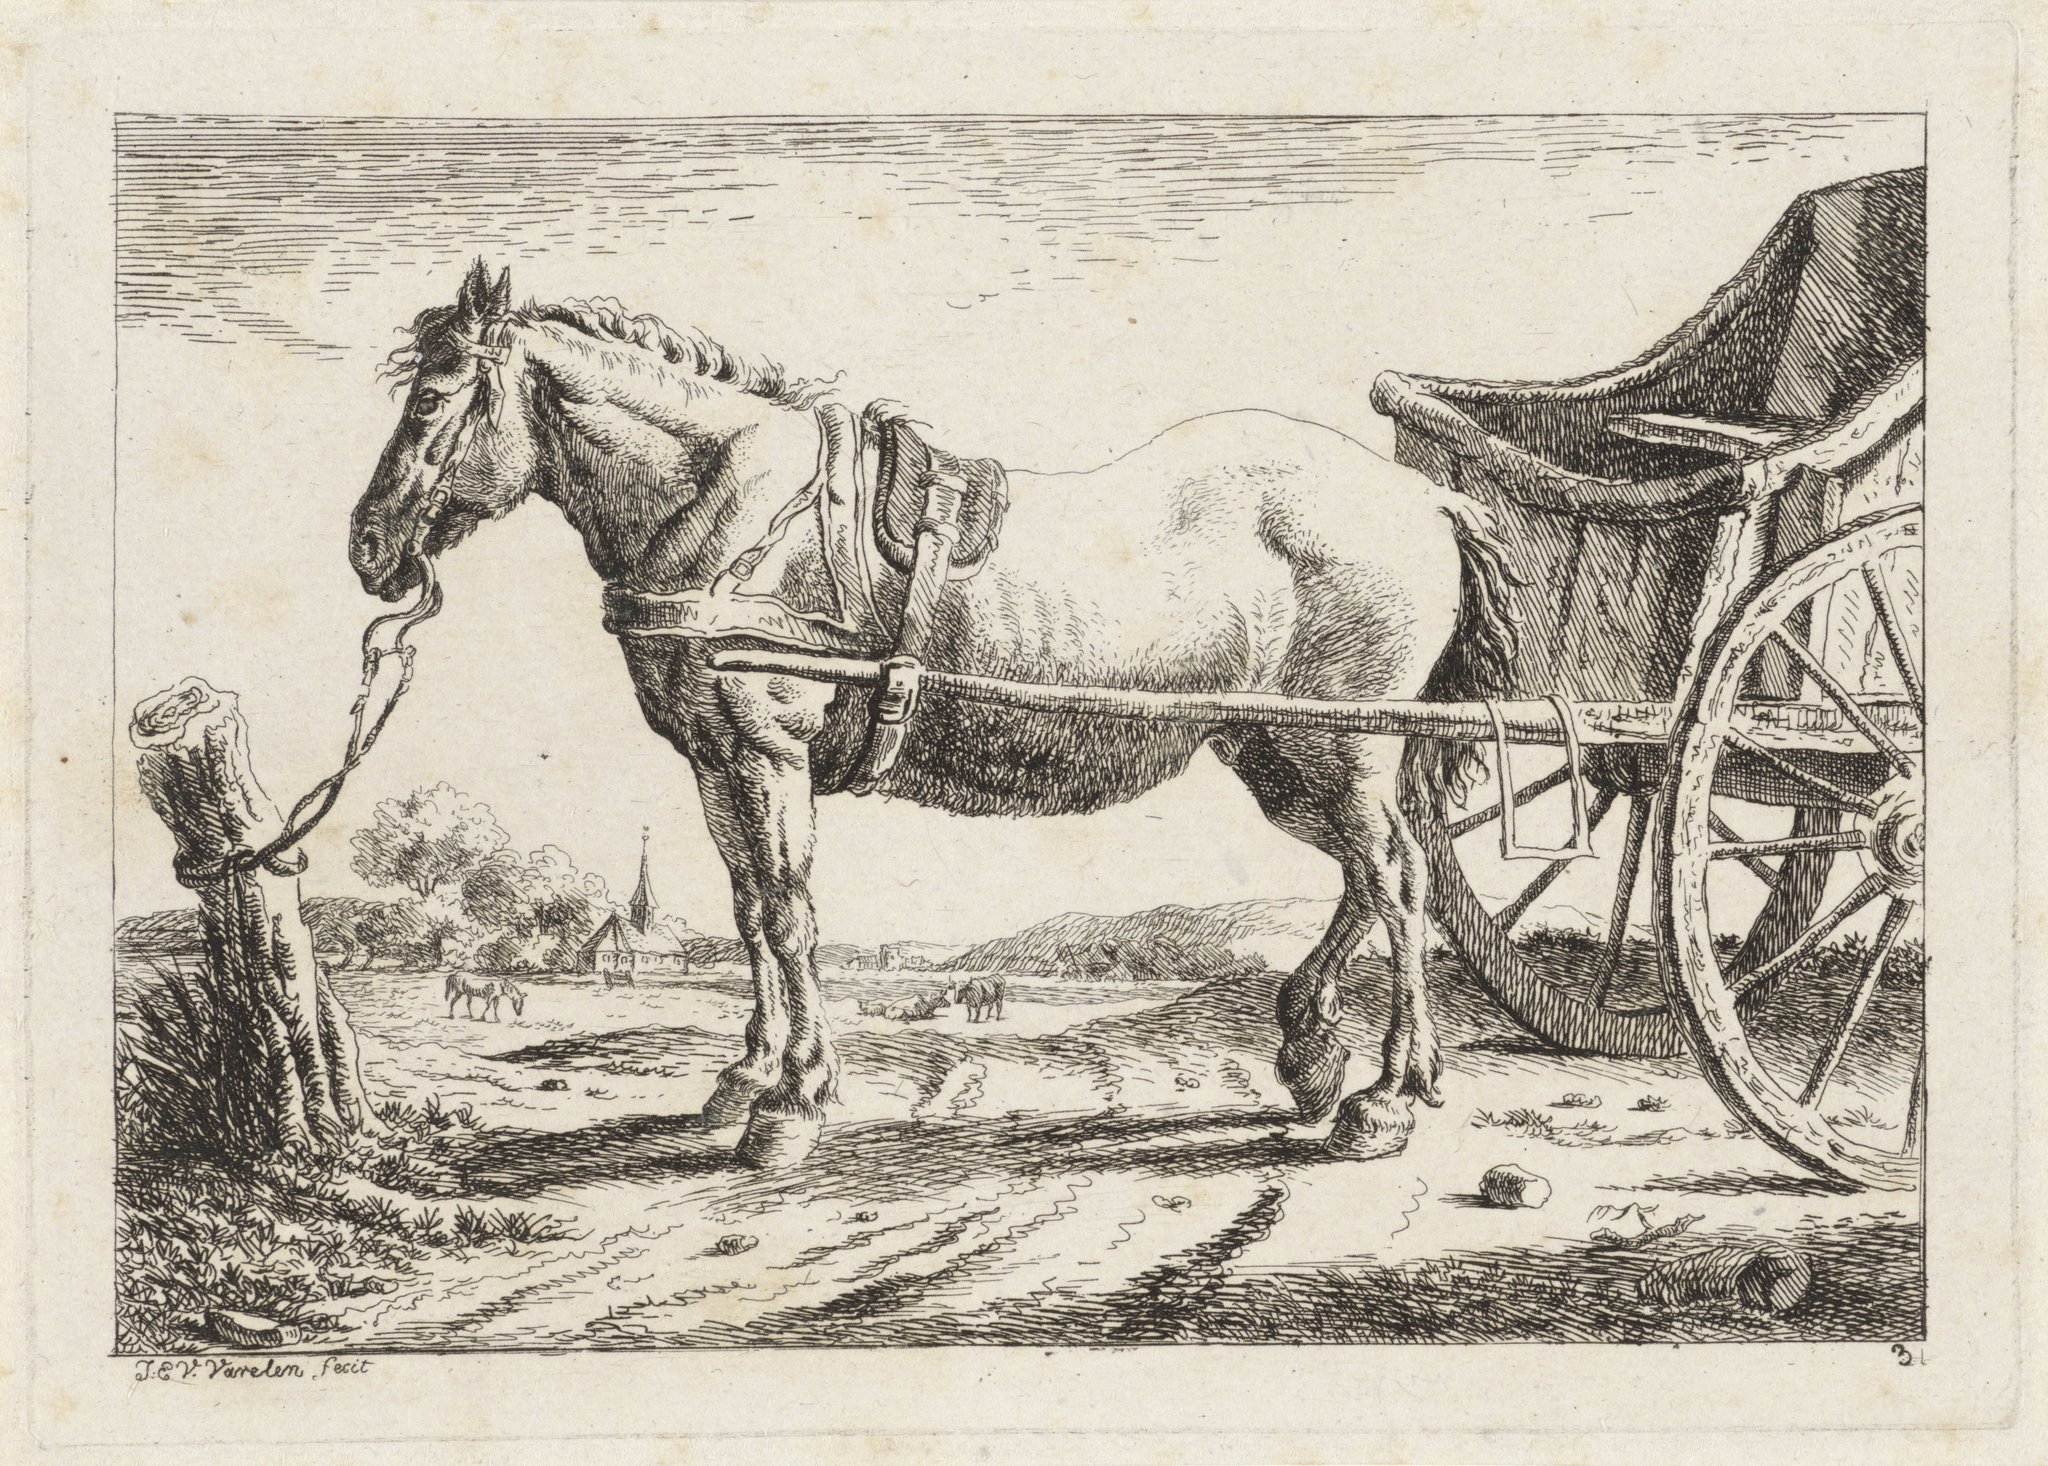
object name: print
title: Staand paard, voor een wagen gespannen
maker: jacob elias van varelen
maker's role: draughtsman, print maker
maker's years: 1757-1840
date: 1772-1840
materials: paper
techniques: etching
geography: haarlem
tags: meadow, pasture, horse, two-wheeled vehicle drawn by one animal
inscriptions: collector's mark: Lugt 2228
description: Staand paard, voor een wagen gespannen en aan het bit vastgemaakt aan een paal. Derde prent van een serie van zes prenten met vee, naar voorbeeld van verschillende meesters.